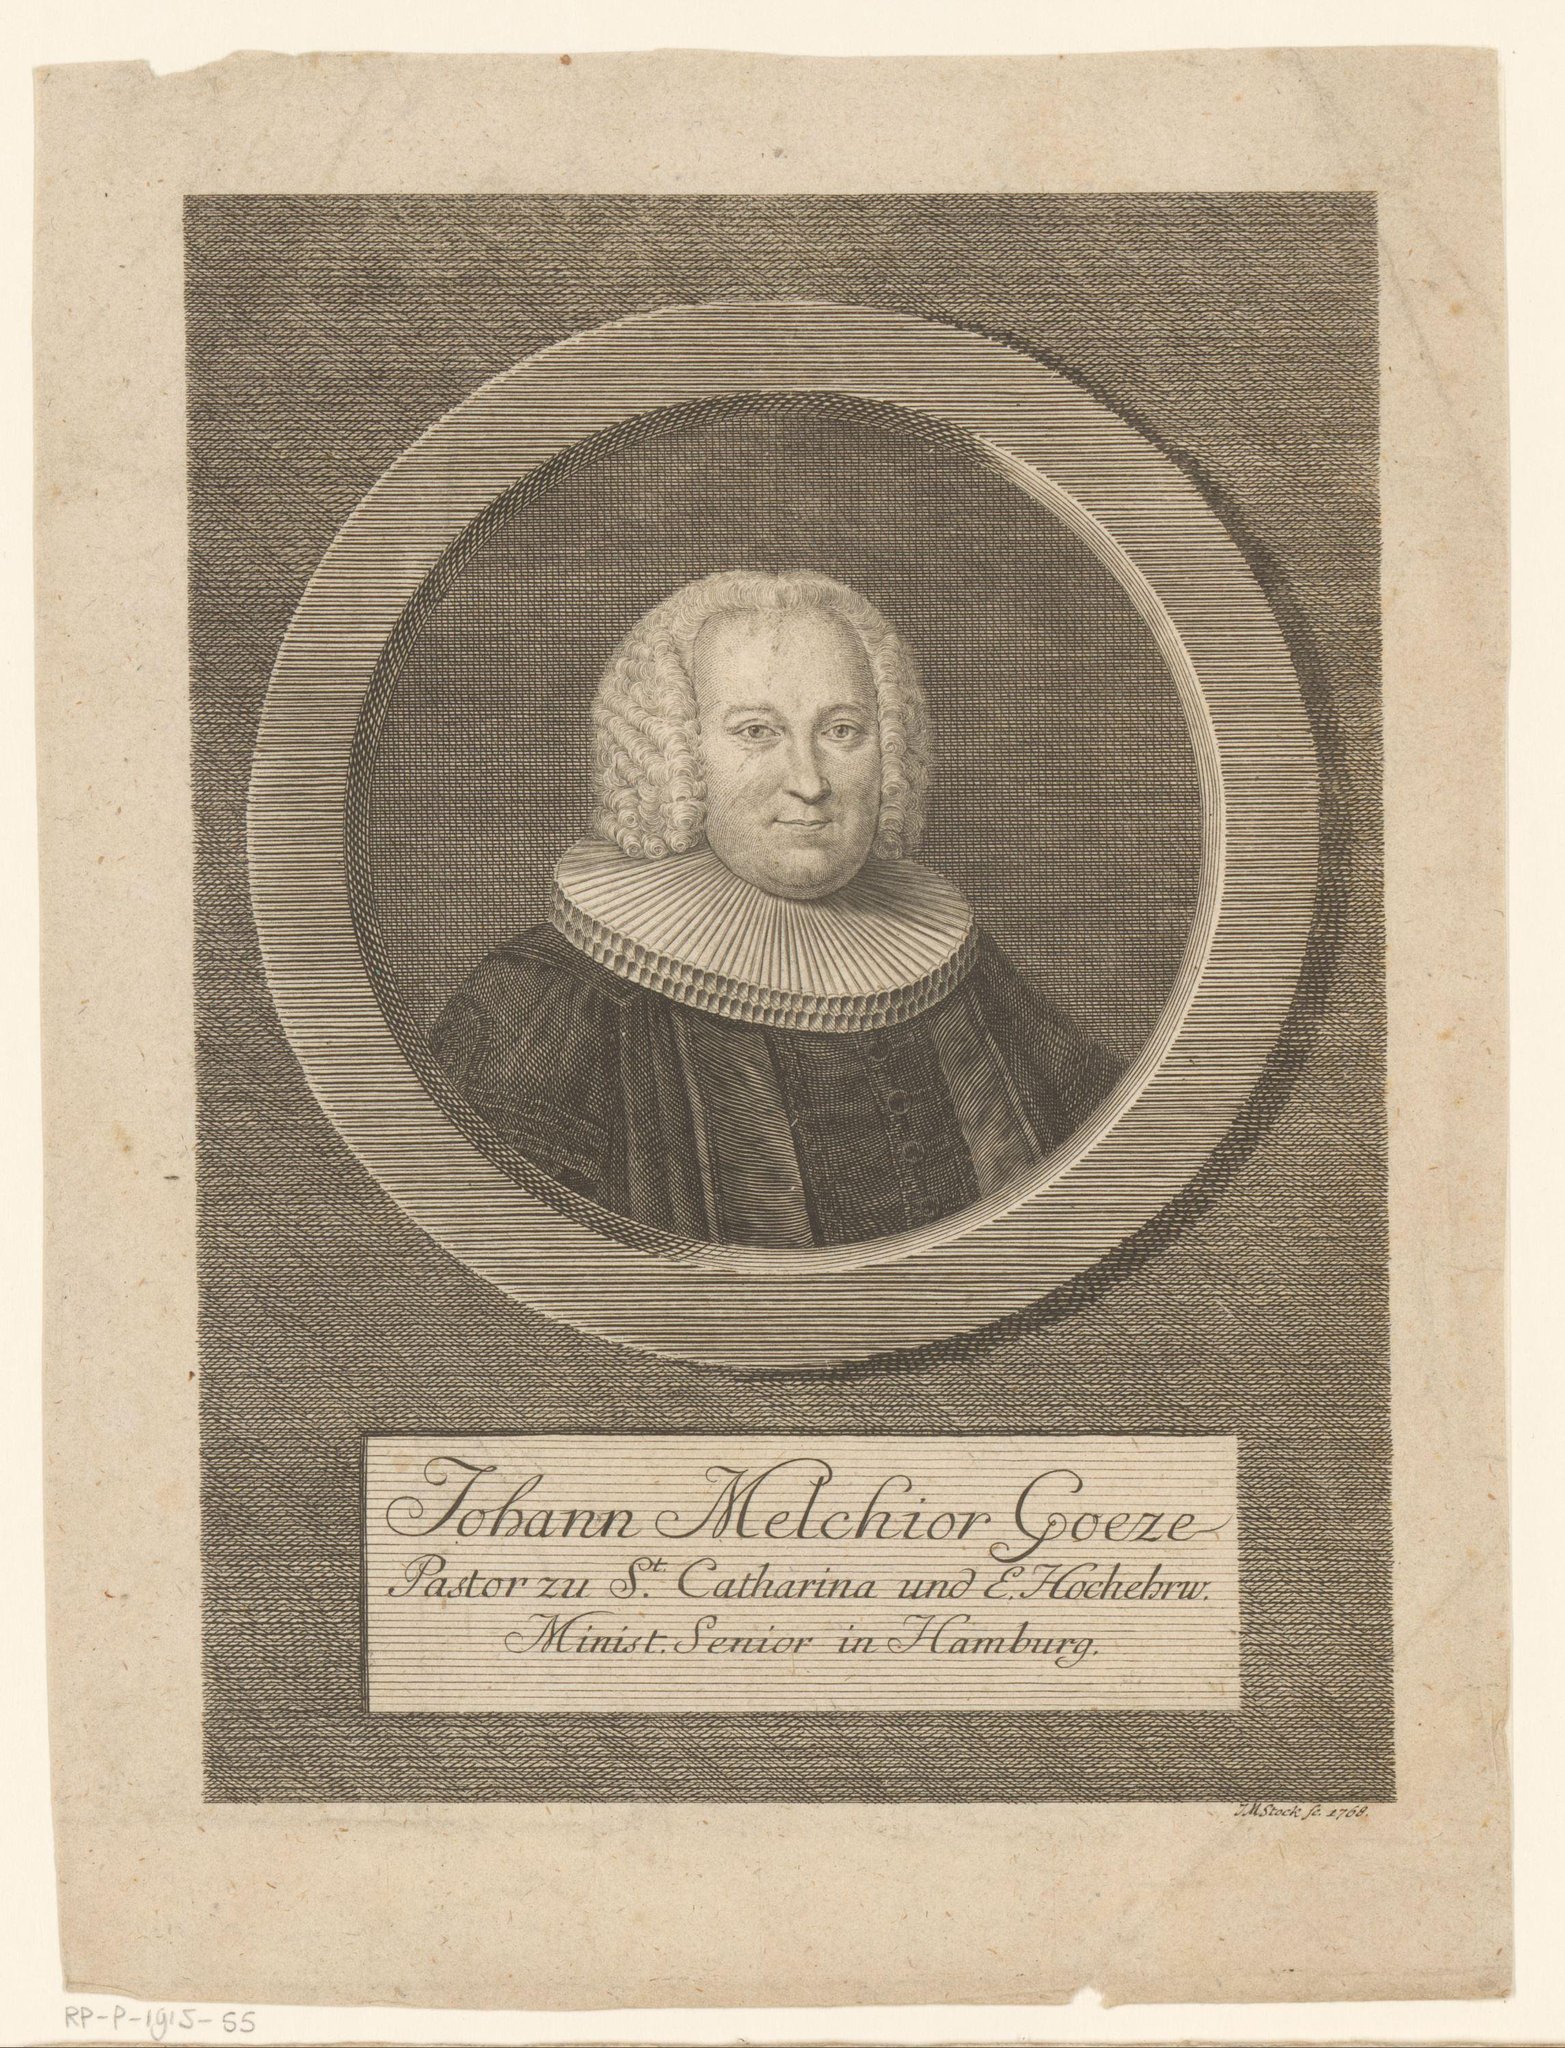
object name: print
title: Portret van Johann Melchior II Goeze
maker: johann michael stock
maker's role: print maker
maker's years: 1737-1773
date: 1768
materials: paper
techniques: engraving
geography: germany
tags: historical persons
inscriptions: collector's mark: Lugt 2228